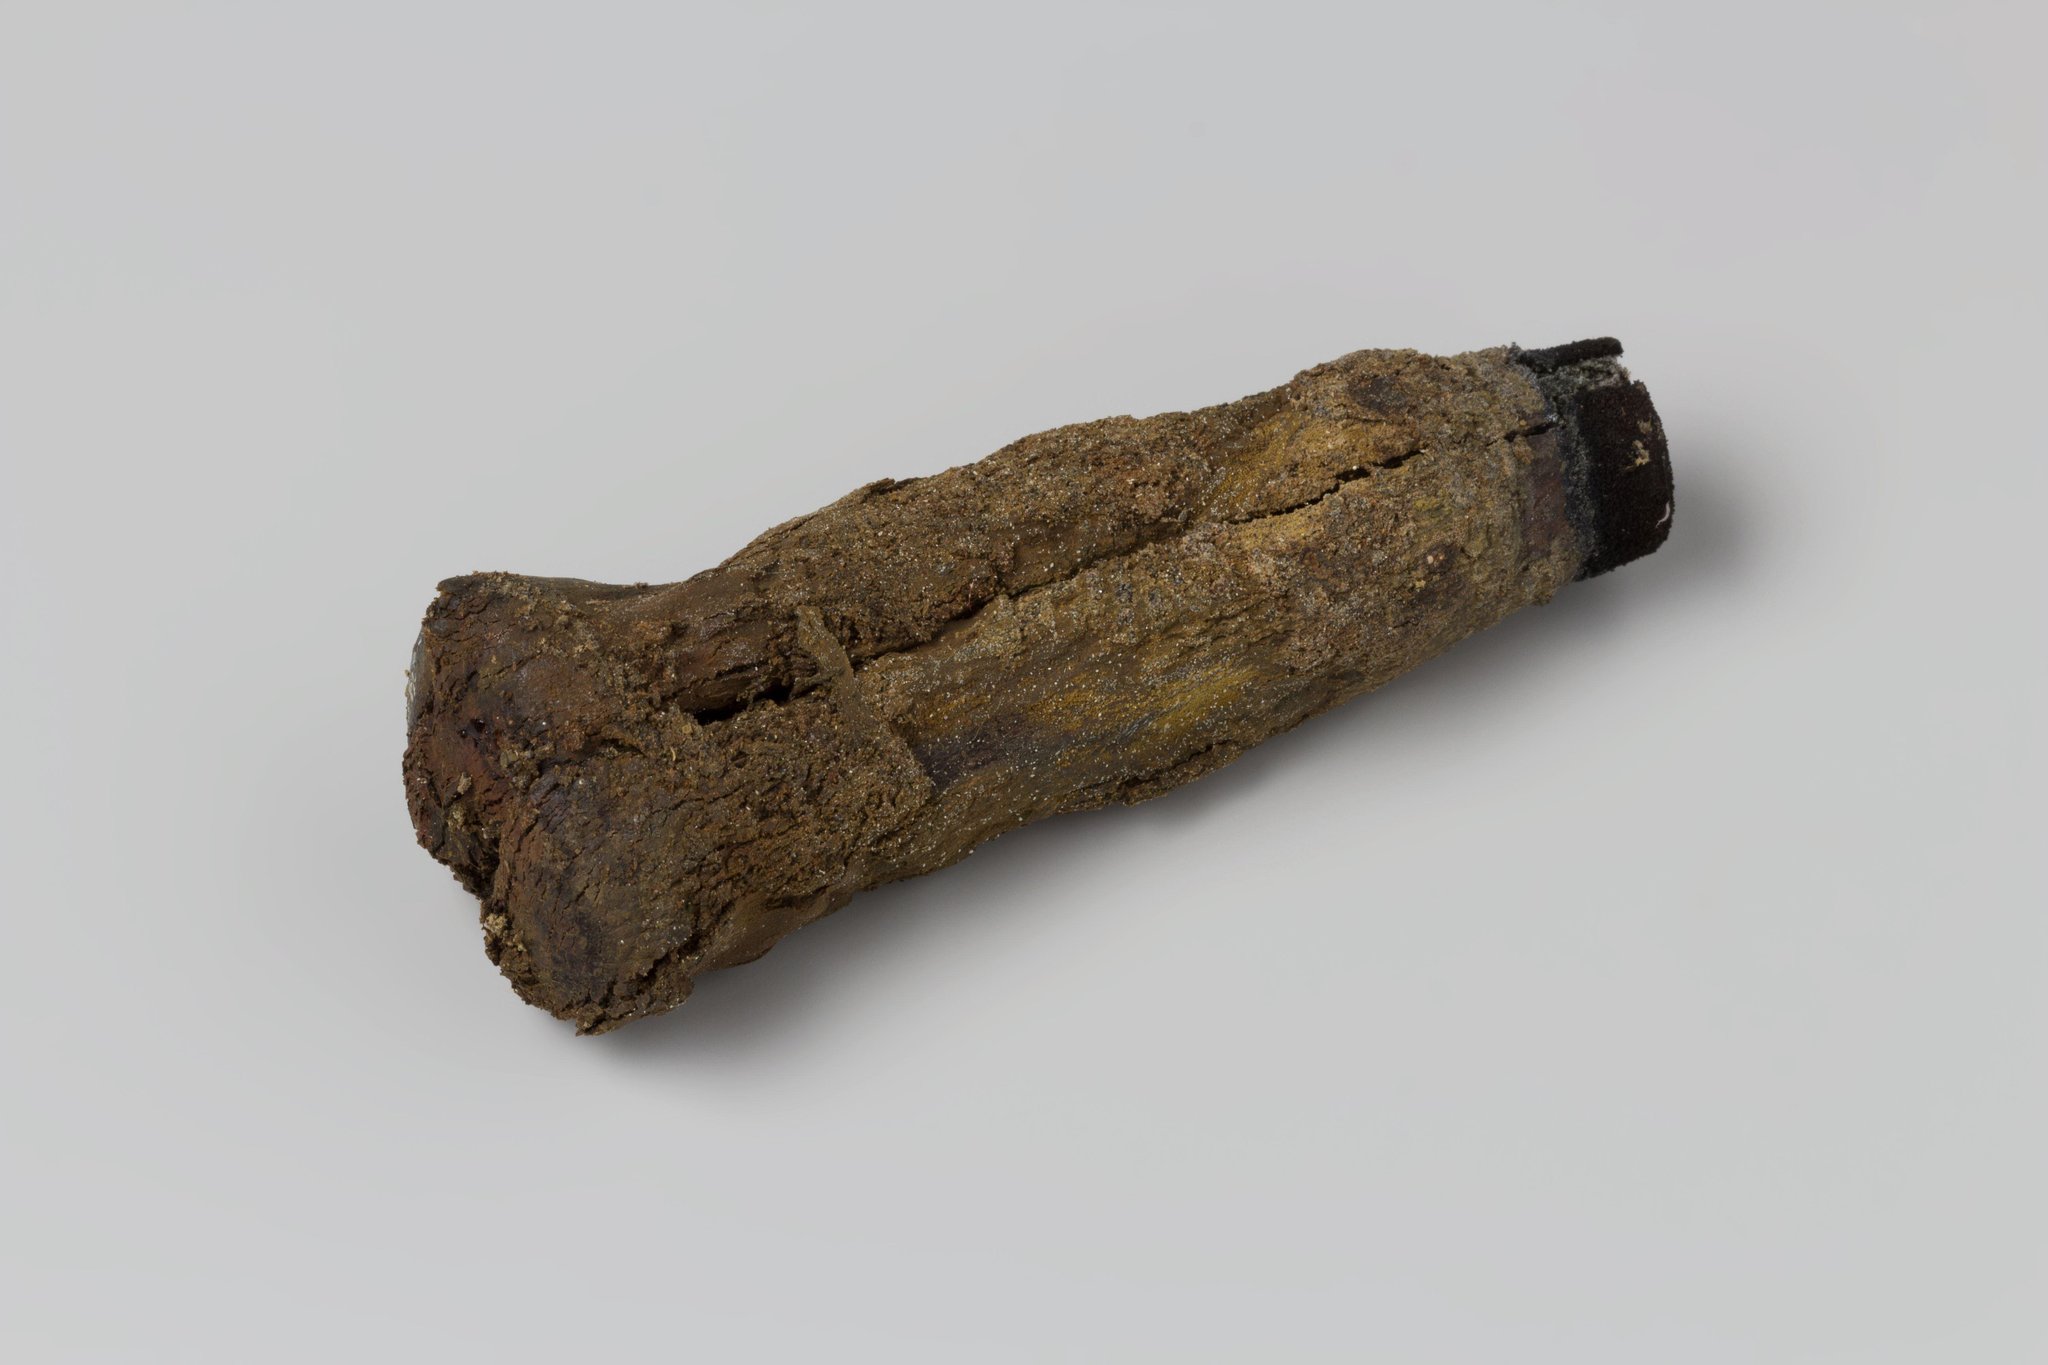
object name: knife handle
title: Messenheft uit het wrak van de Oost-Indiëvaarder Hollandia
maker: Anonymous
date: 1700-1743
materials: copper, wood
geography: netherlands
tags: verenigde oostindische compagnie, hollandia (schip), annet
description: Knife, handle, cylindrical: tapering; id. NG 1979-403H, eroded.